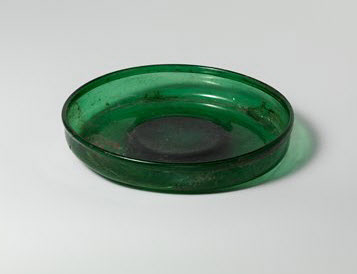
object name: dish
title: Glass dish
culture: roman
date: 34-66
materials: glass